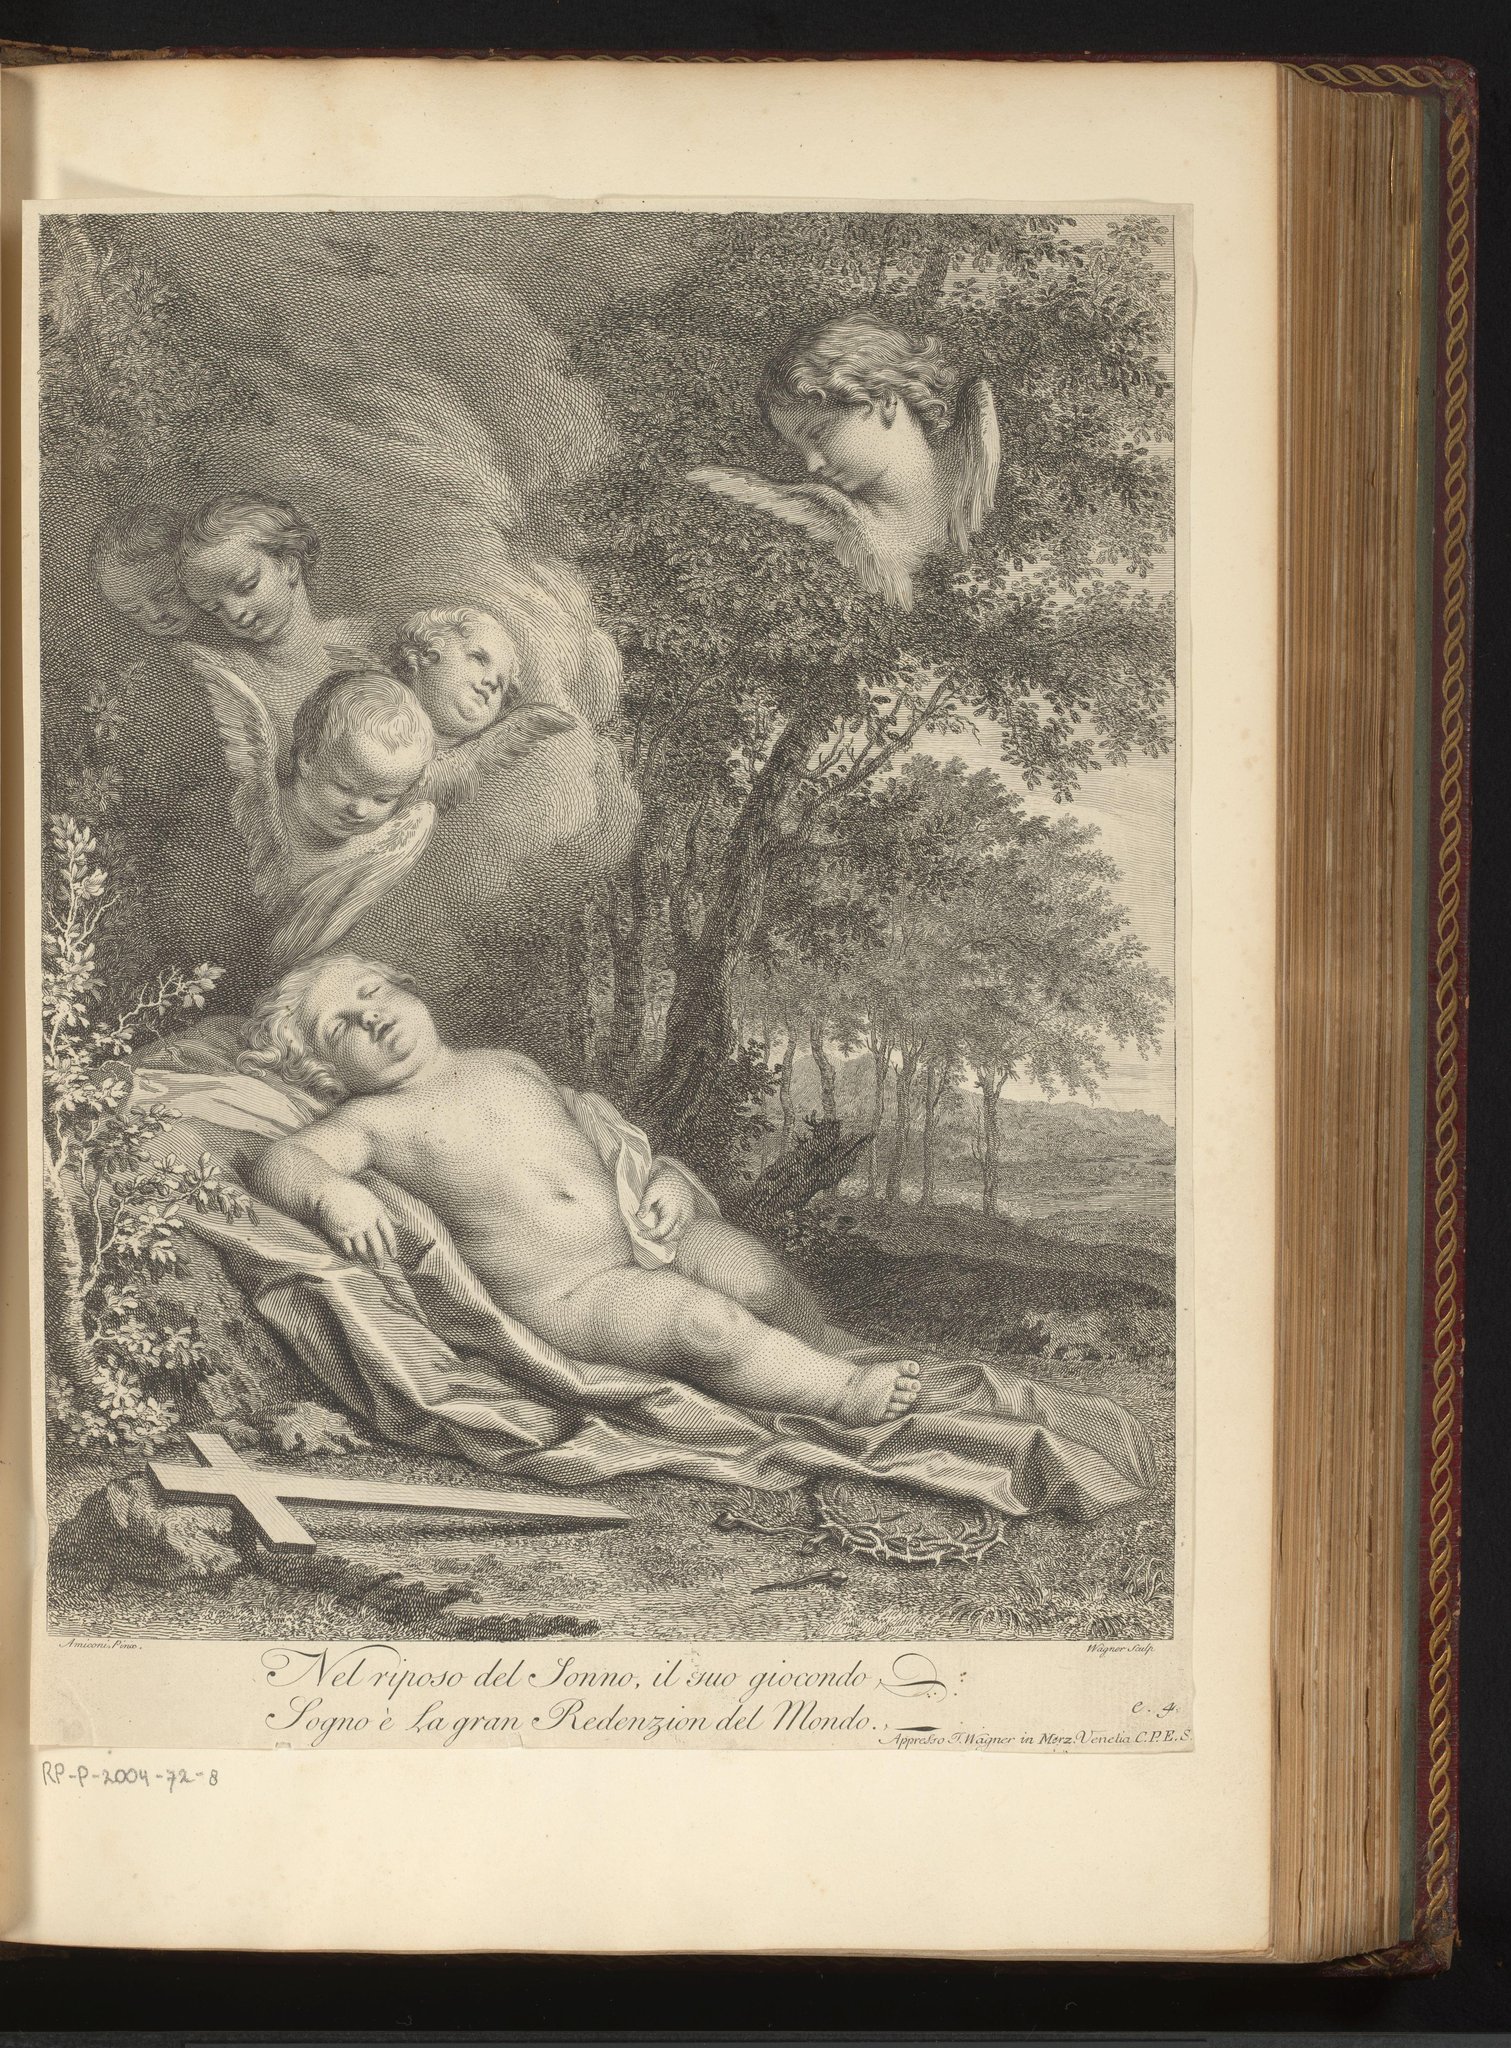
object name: album leaf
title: Nel riposo del sonno, il suo giocondo sogno è la gran redenzion del mondo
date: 1716-1780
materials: paper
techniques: engraving, etching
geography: venice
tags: 'arma christi', christ-child together with others (+ angels floating in the air)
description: De samensteller heeft deze prent in het album geplakt als illustratie bij: Pilkington, Matthew en Johann Heinrich Füssli. A dictionary of painters, from the revival of the art to the present period. 4 dln. Londen: John Crowder, 1805, dl. 1, p. 10.